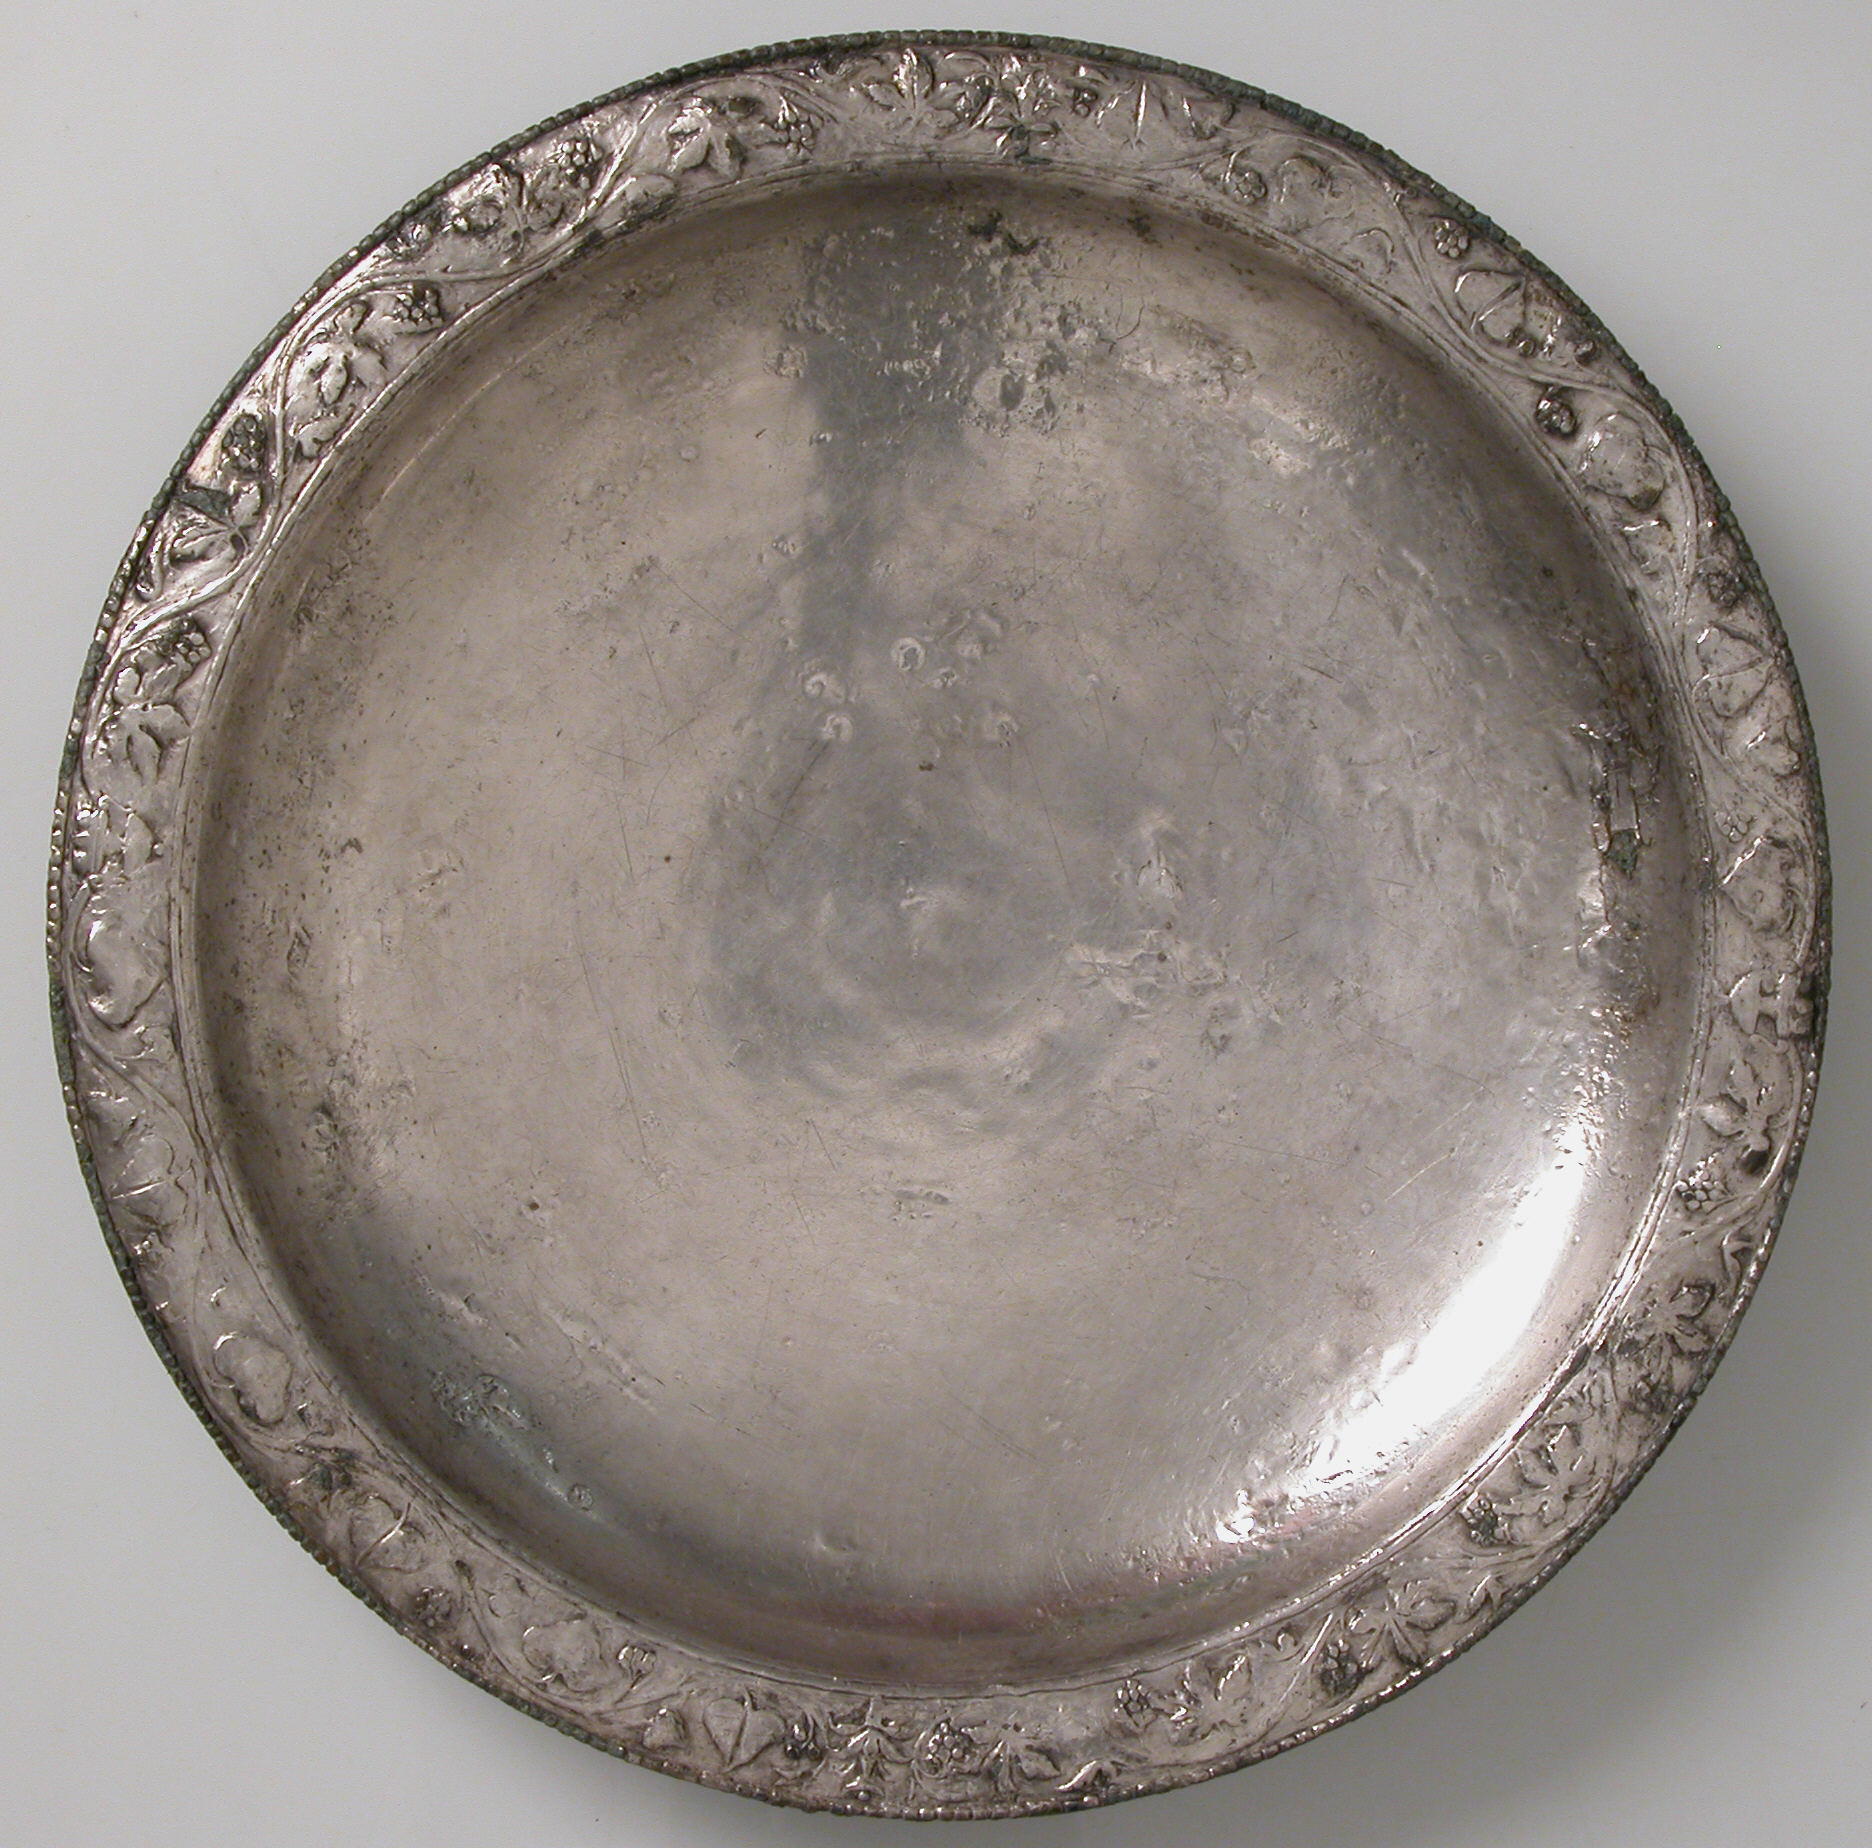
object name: dish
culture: roman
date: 301-400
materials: bronze, silver